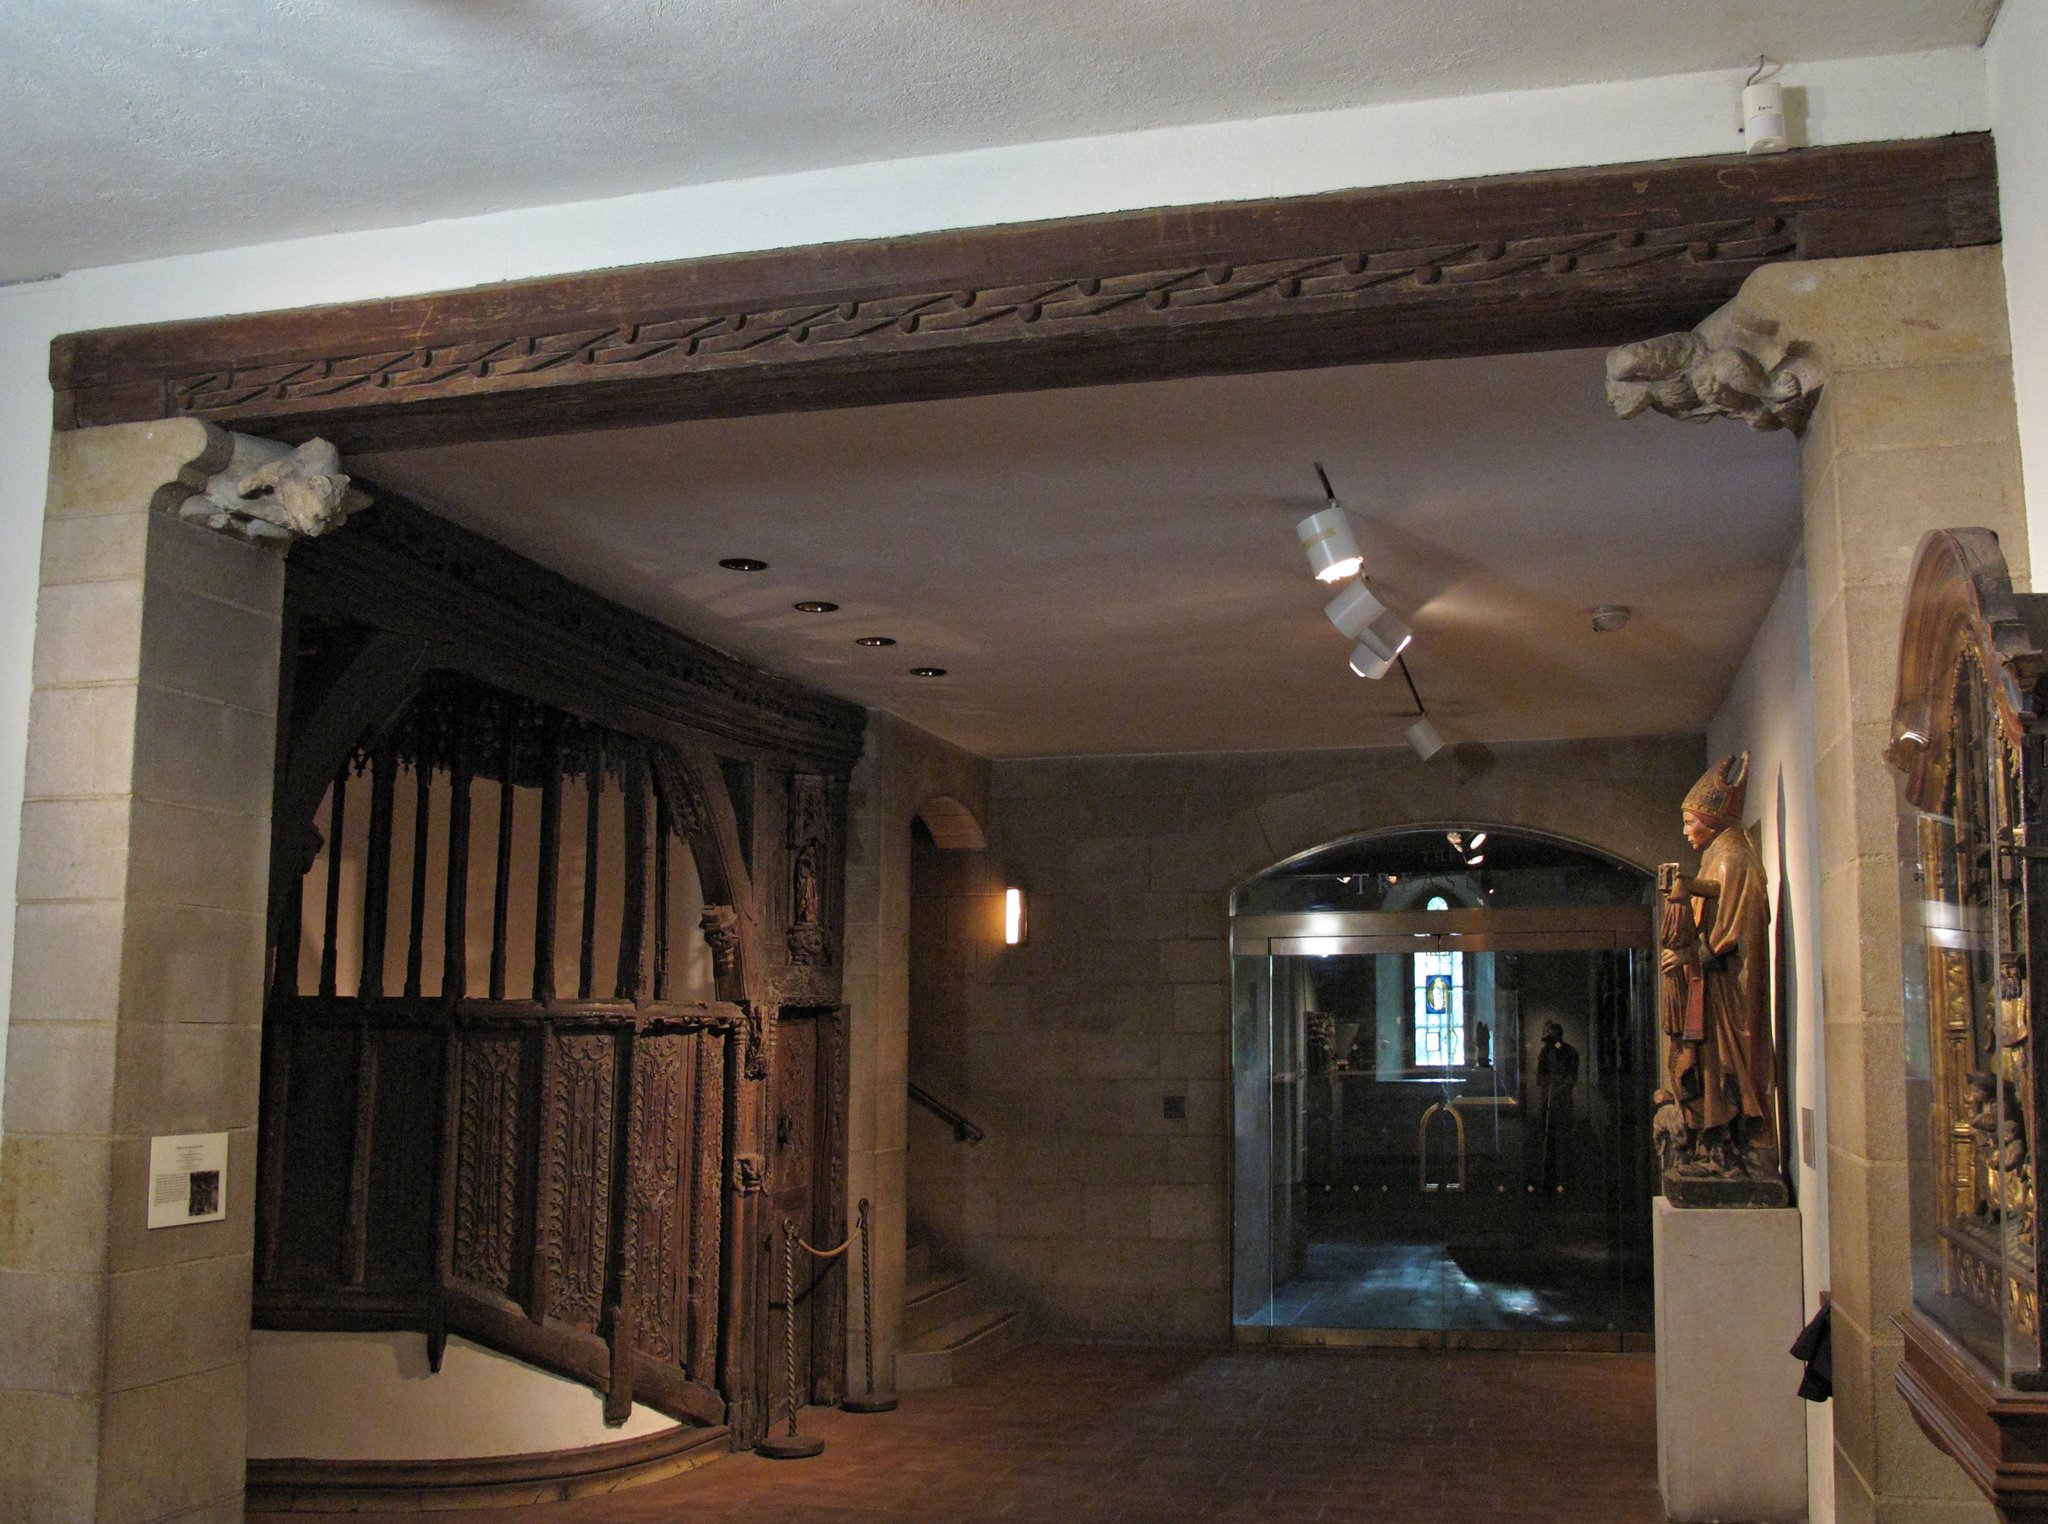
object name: beam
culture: european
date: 1401-1700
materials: wood